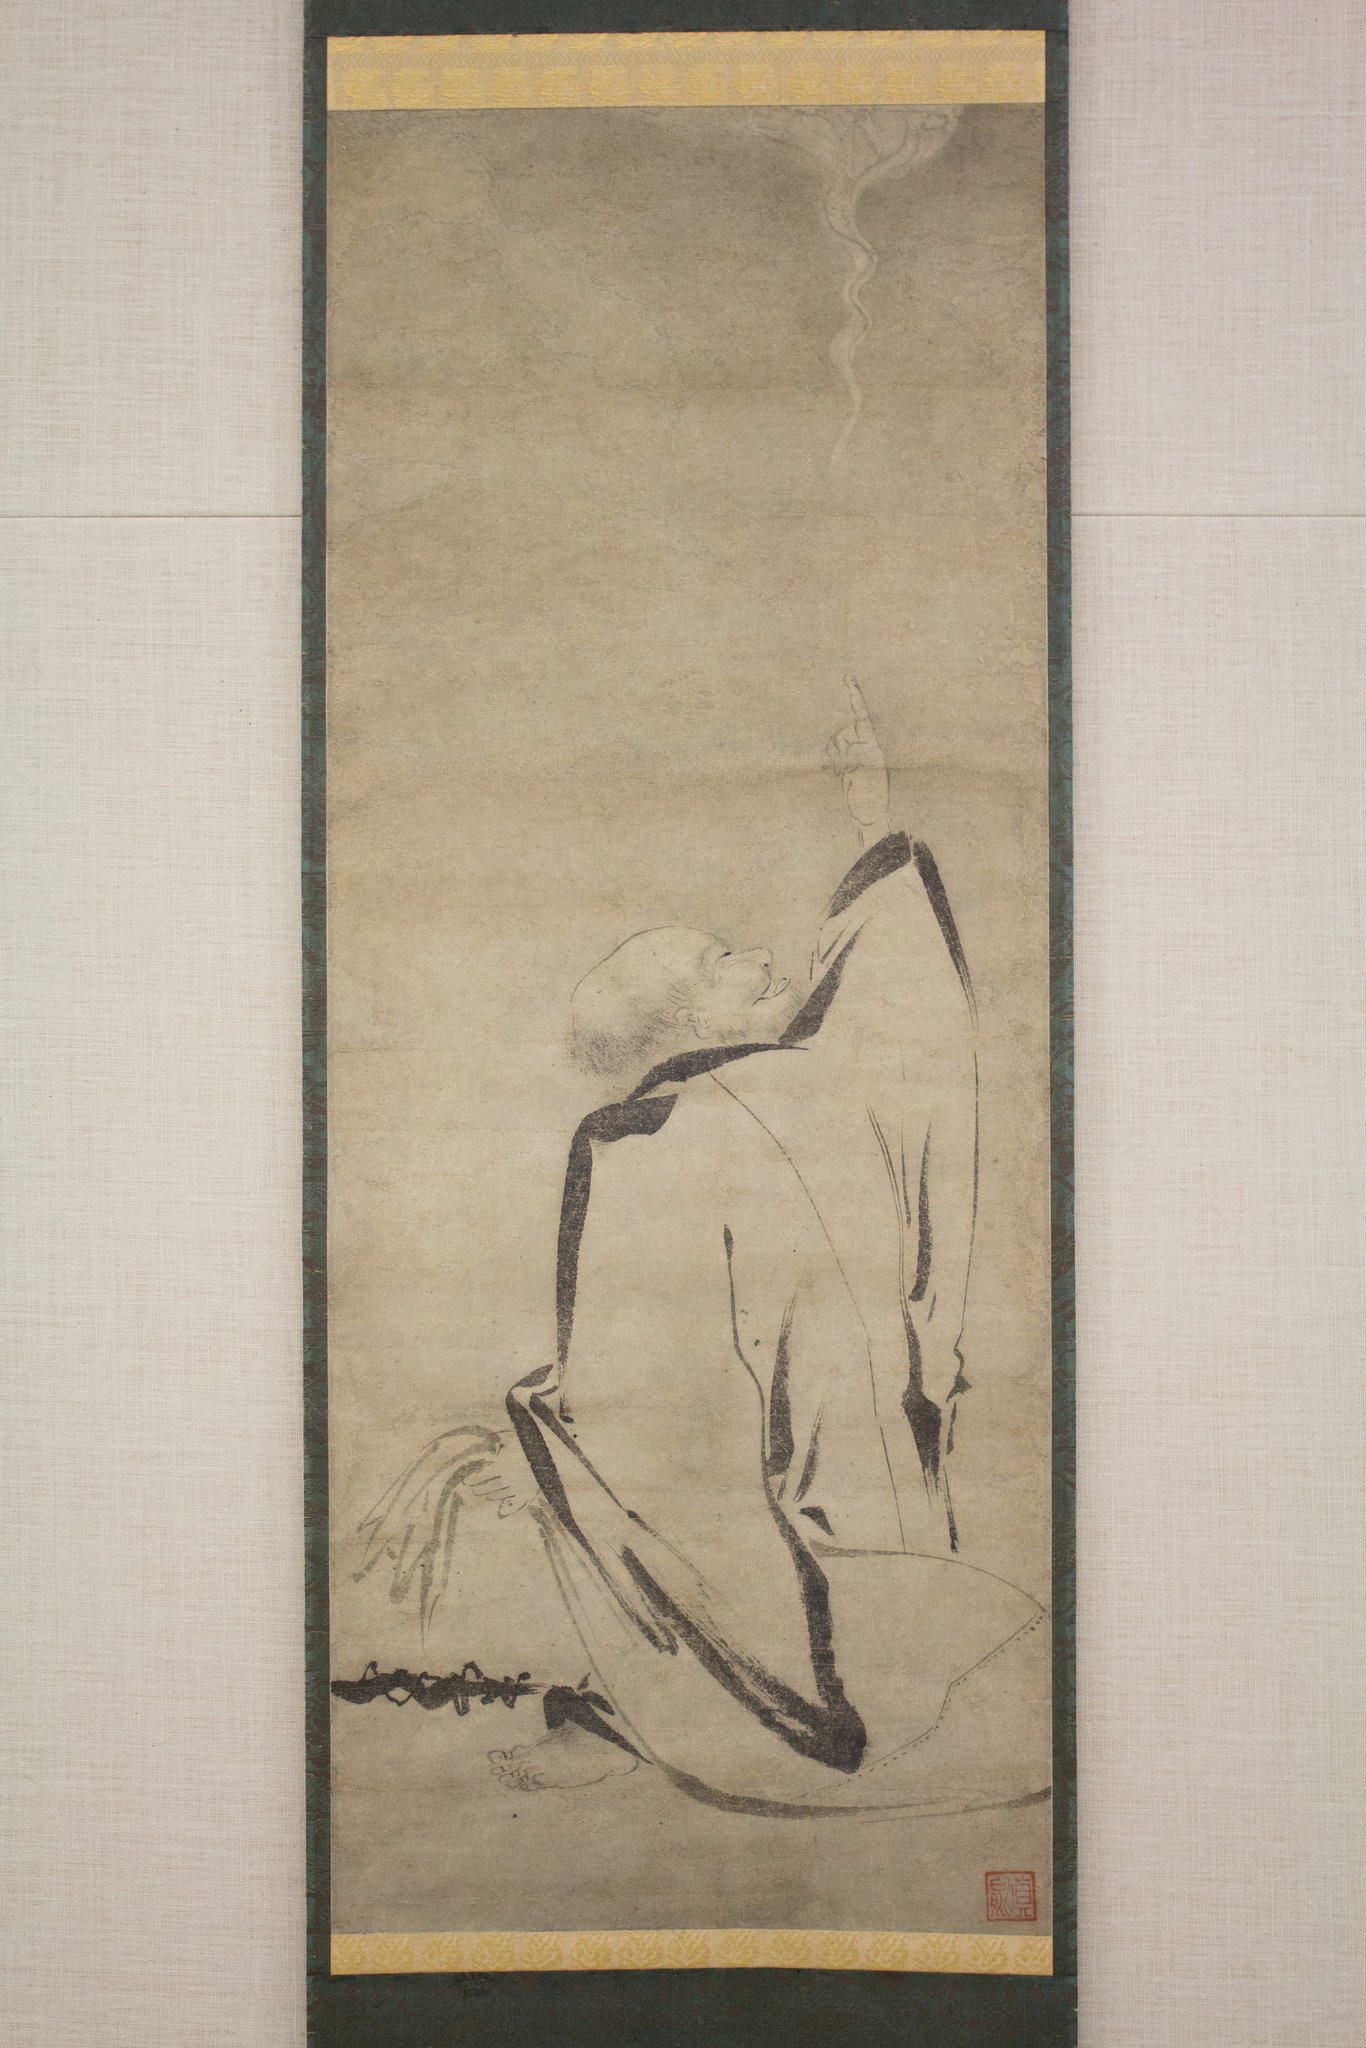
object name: hanging scroll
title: Hōtei Pointing to the Moon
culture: japanese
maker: shinno noami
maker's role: artist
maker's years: 1397-1471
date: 1401-1500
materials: ink, paper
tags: men